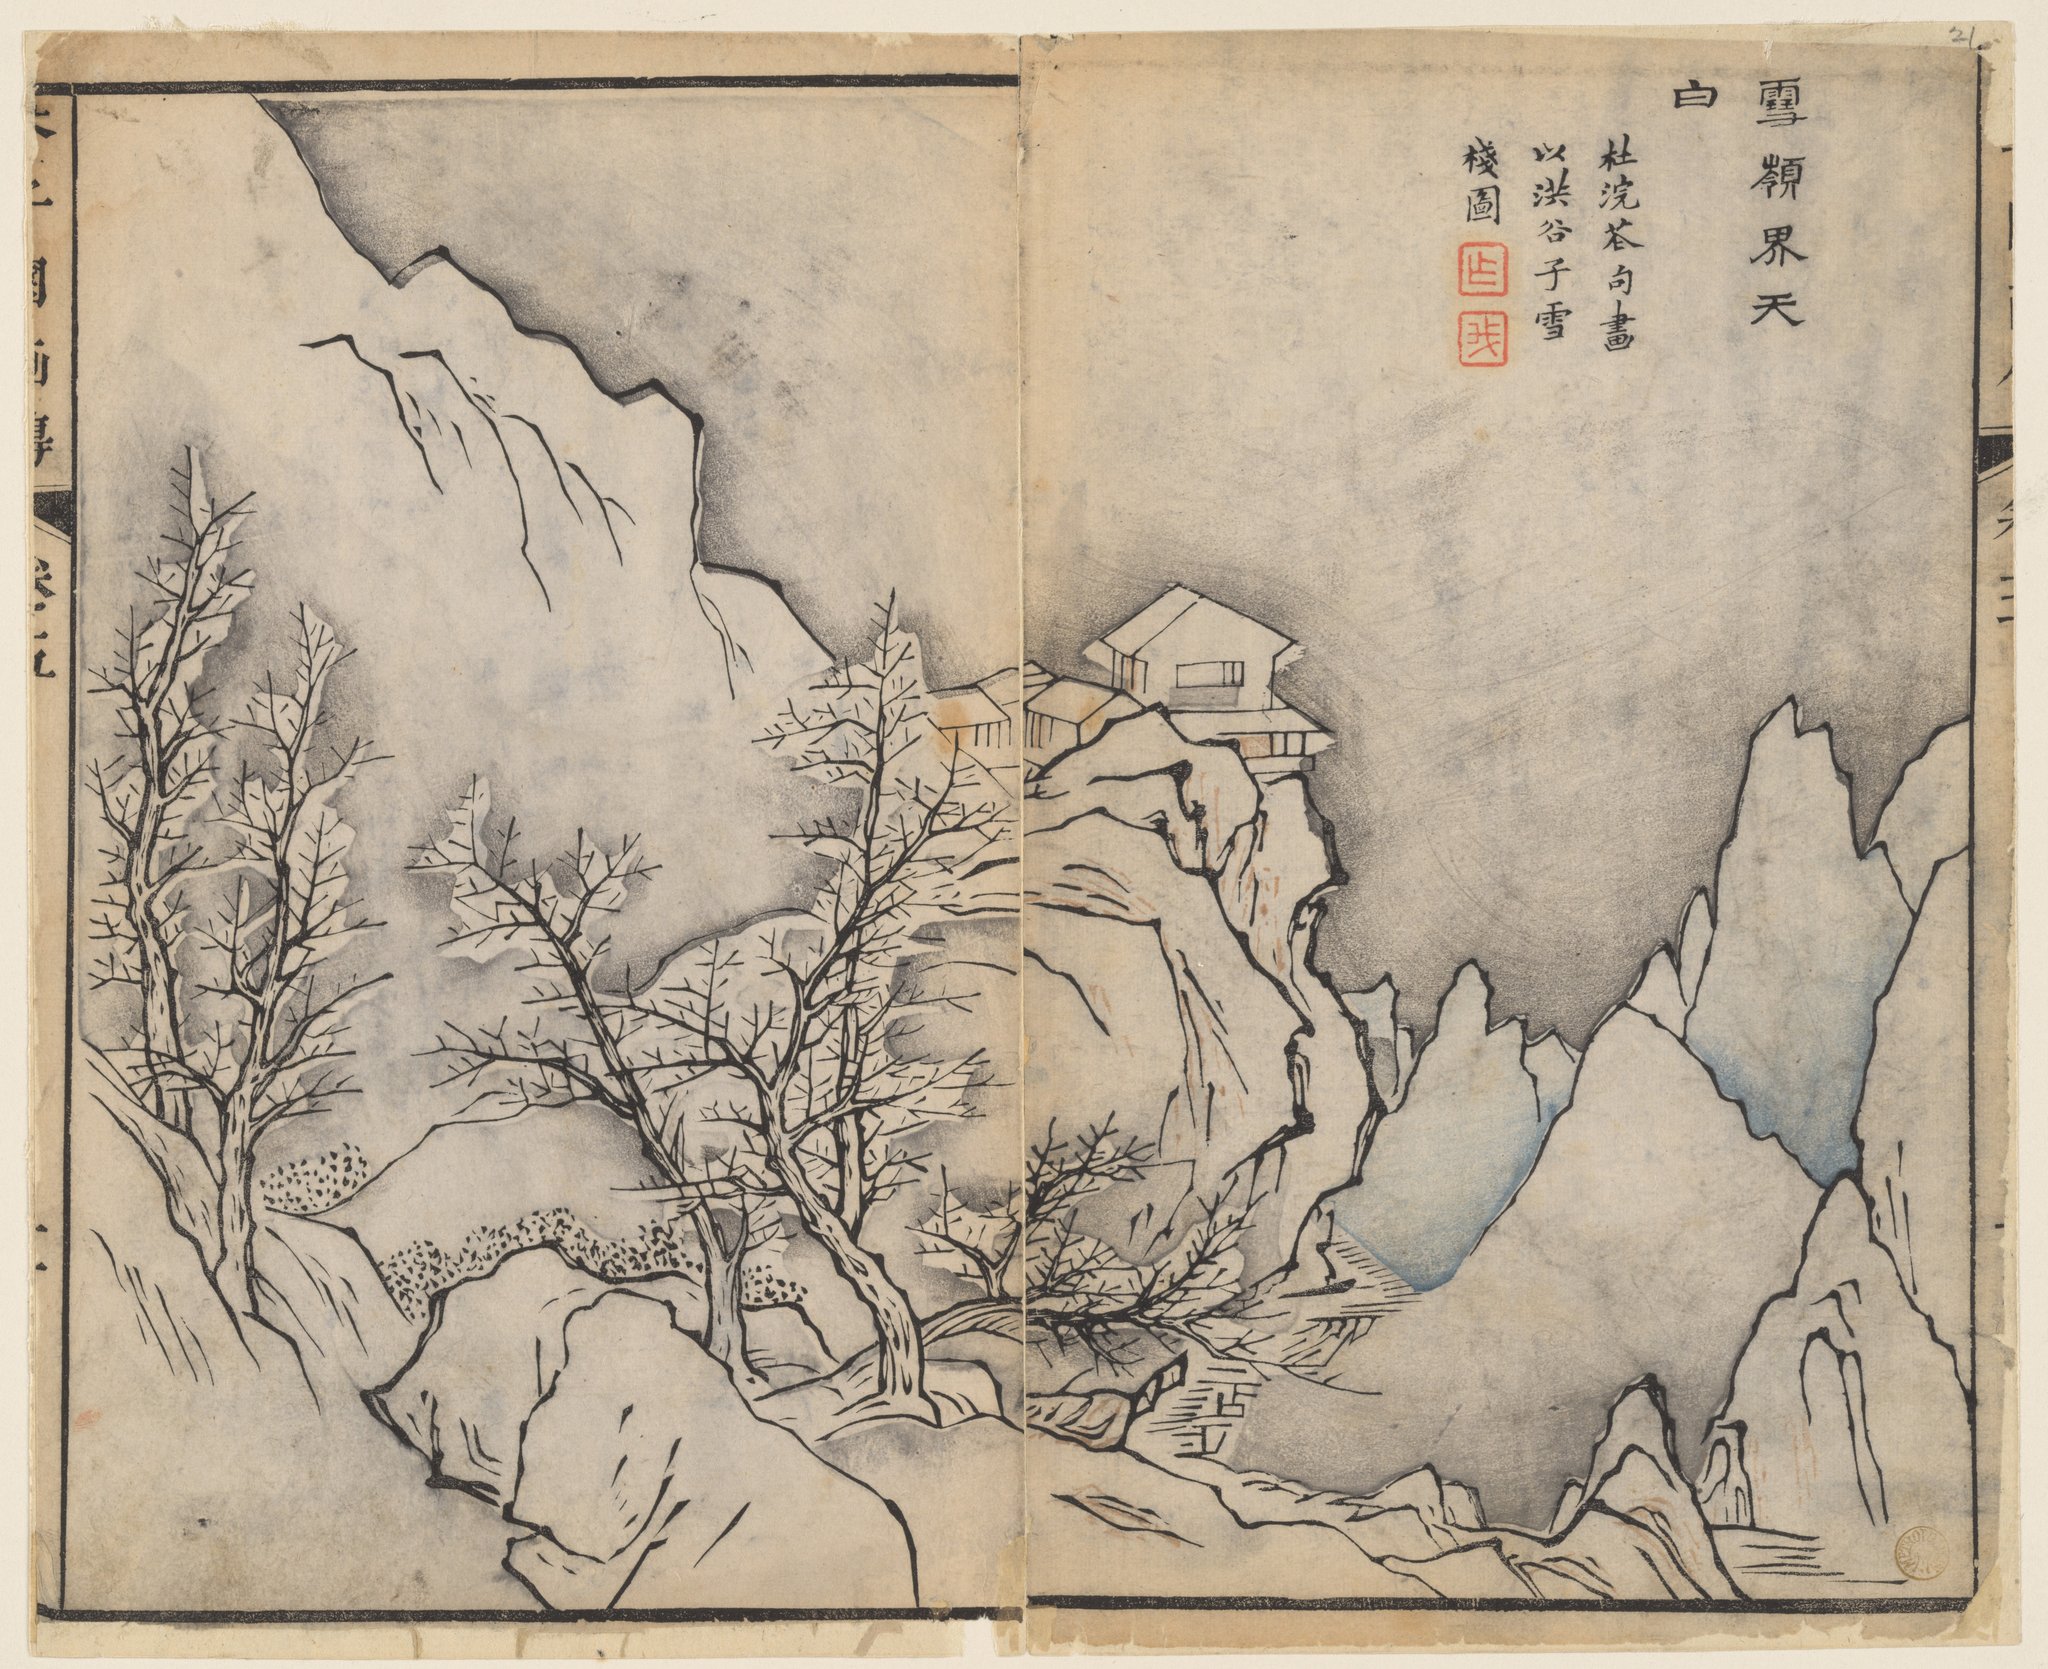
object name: print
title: Page from the Mustard Seed Garden Manual of Painting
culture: chinese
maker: wang gai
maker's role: artist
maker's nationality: chinese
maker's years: 1645-1710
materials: ink, paper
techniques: woodblock print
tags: landscapes,snow